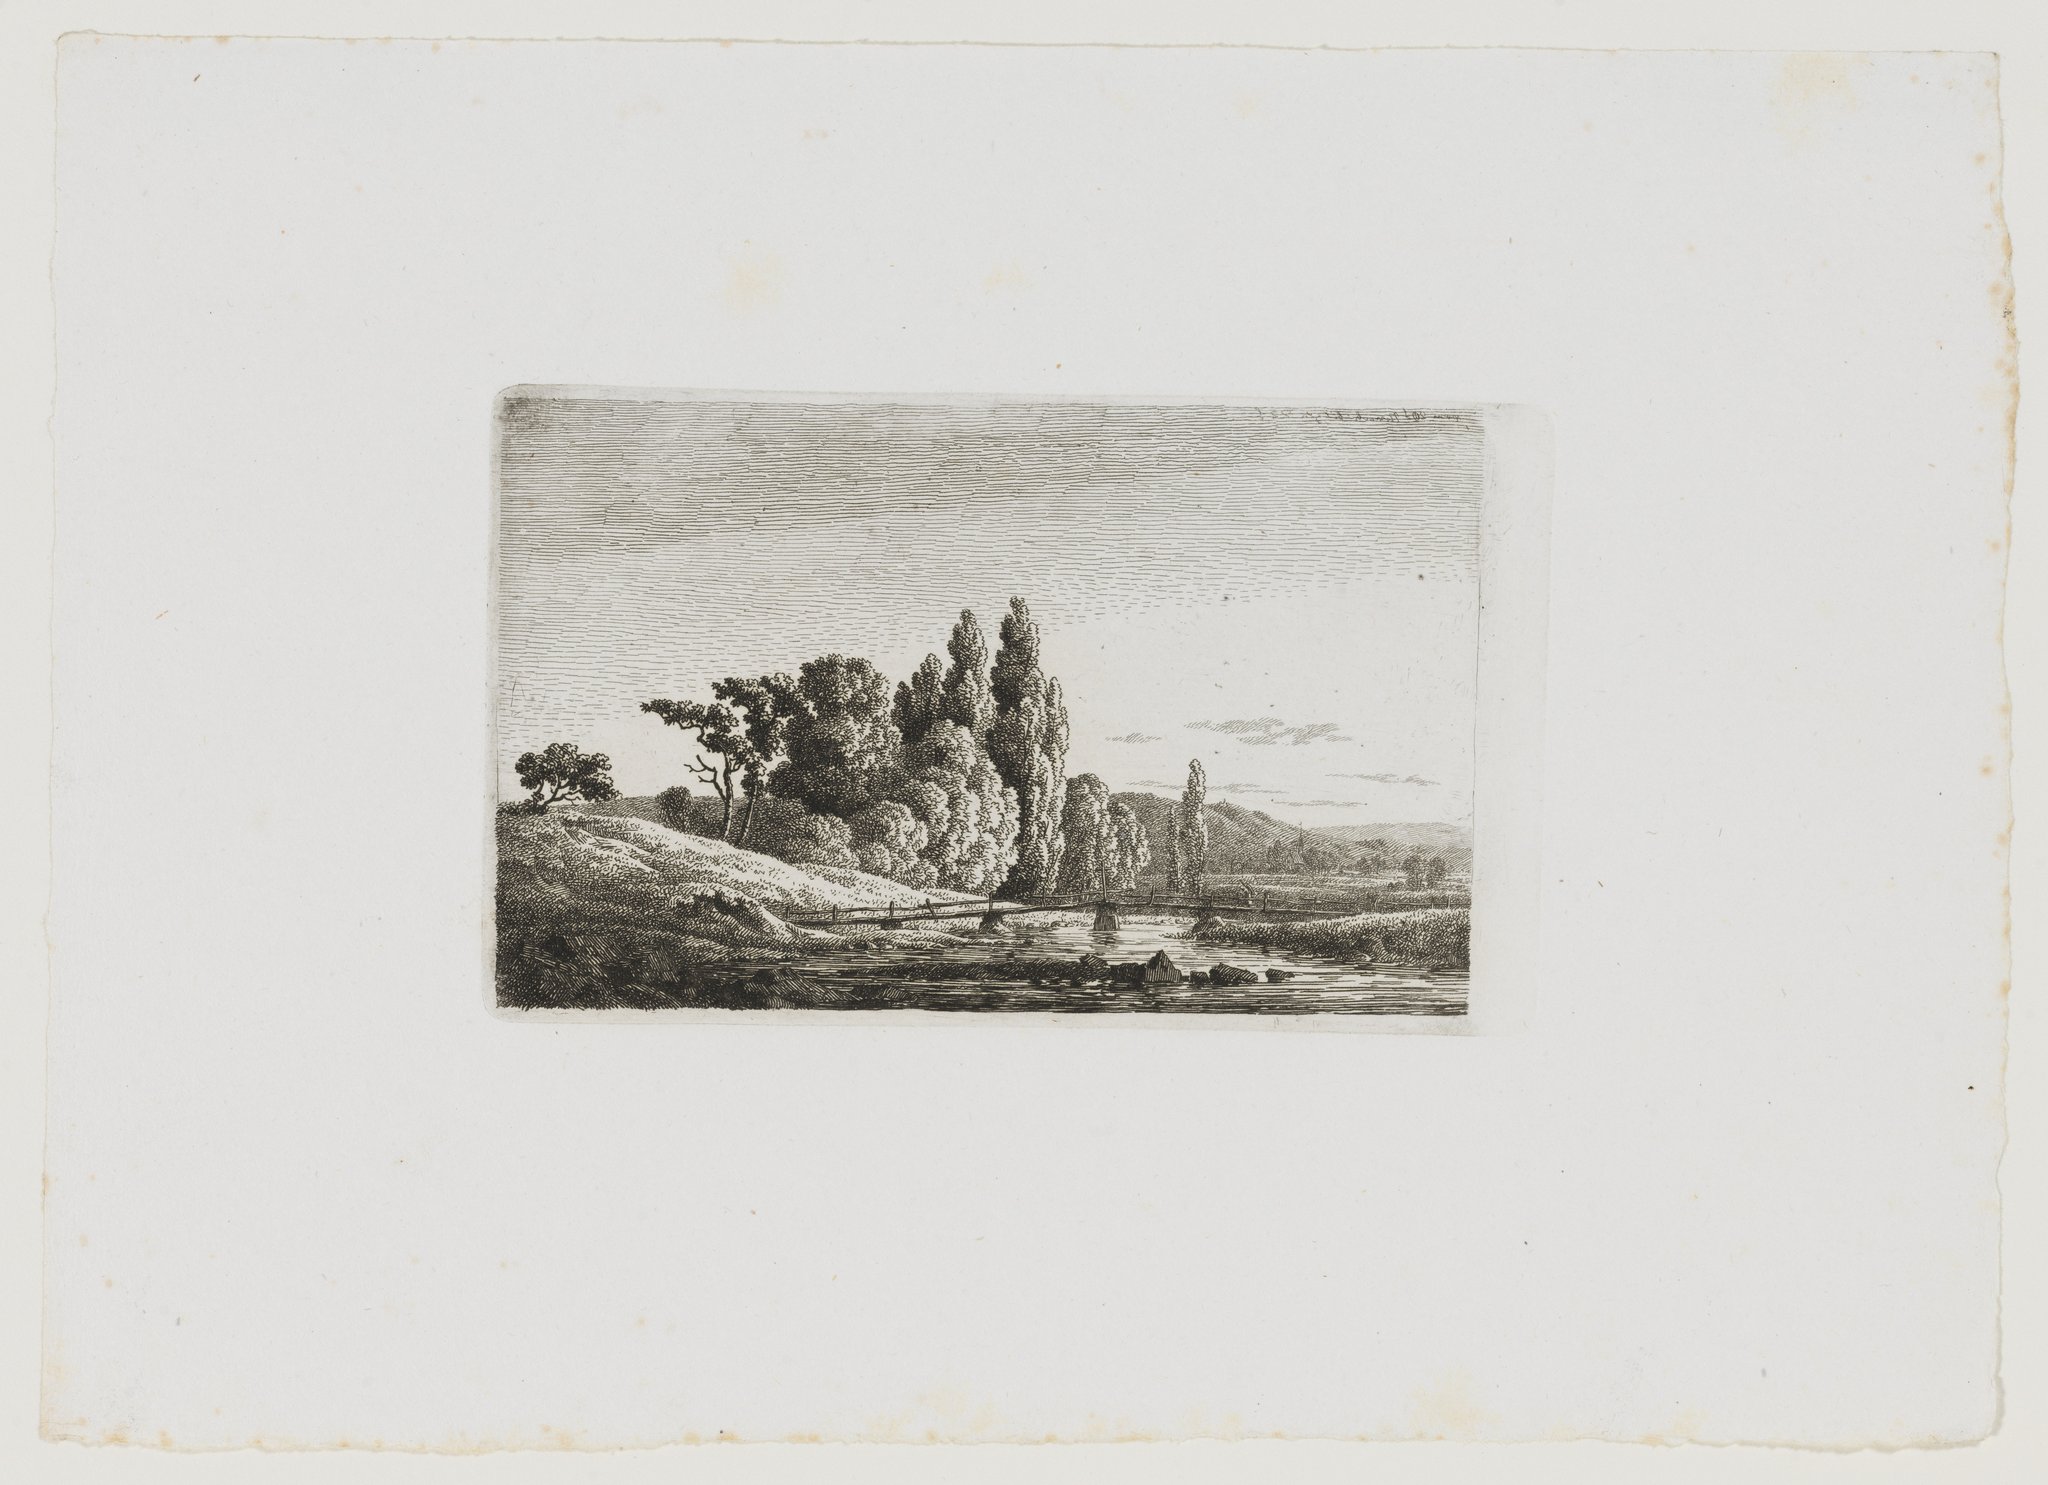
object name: print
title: Footpath with a Bridge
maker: caspar david friedrich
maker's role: artist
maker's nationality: german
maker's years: 1774-1840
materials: paper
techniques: etching